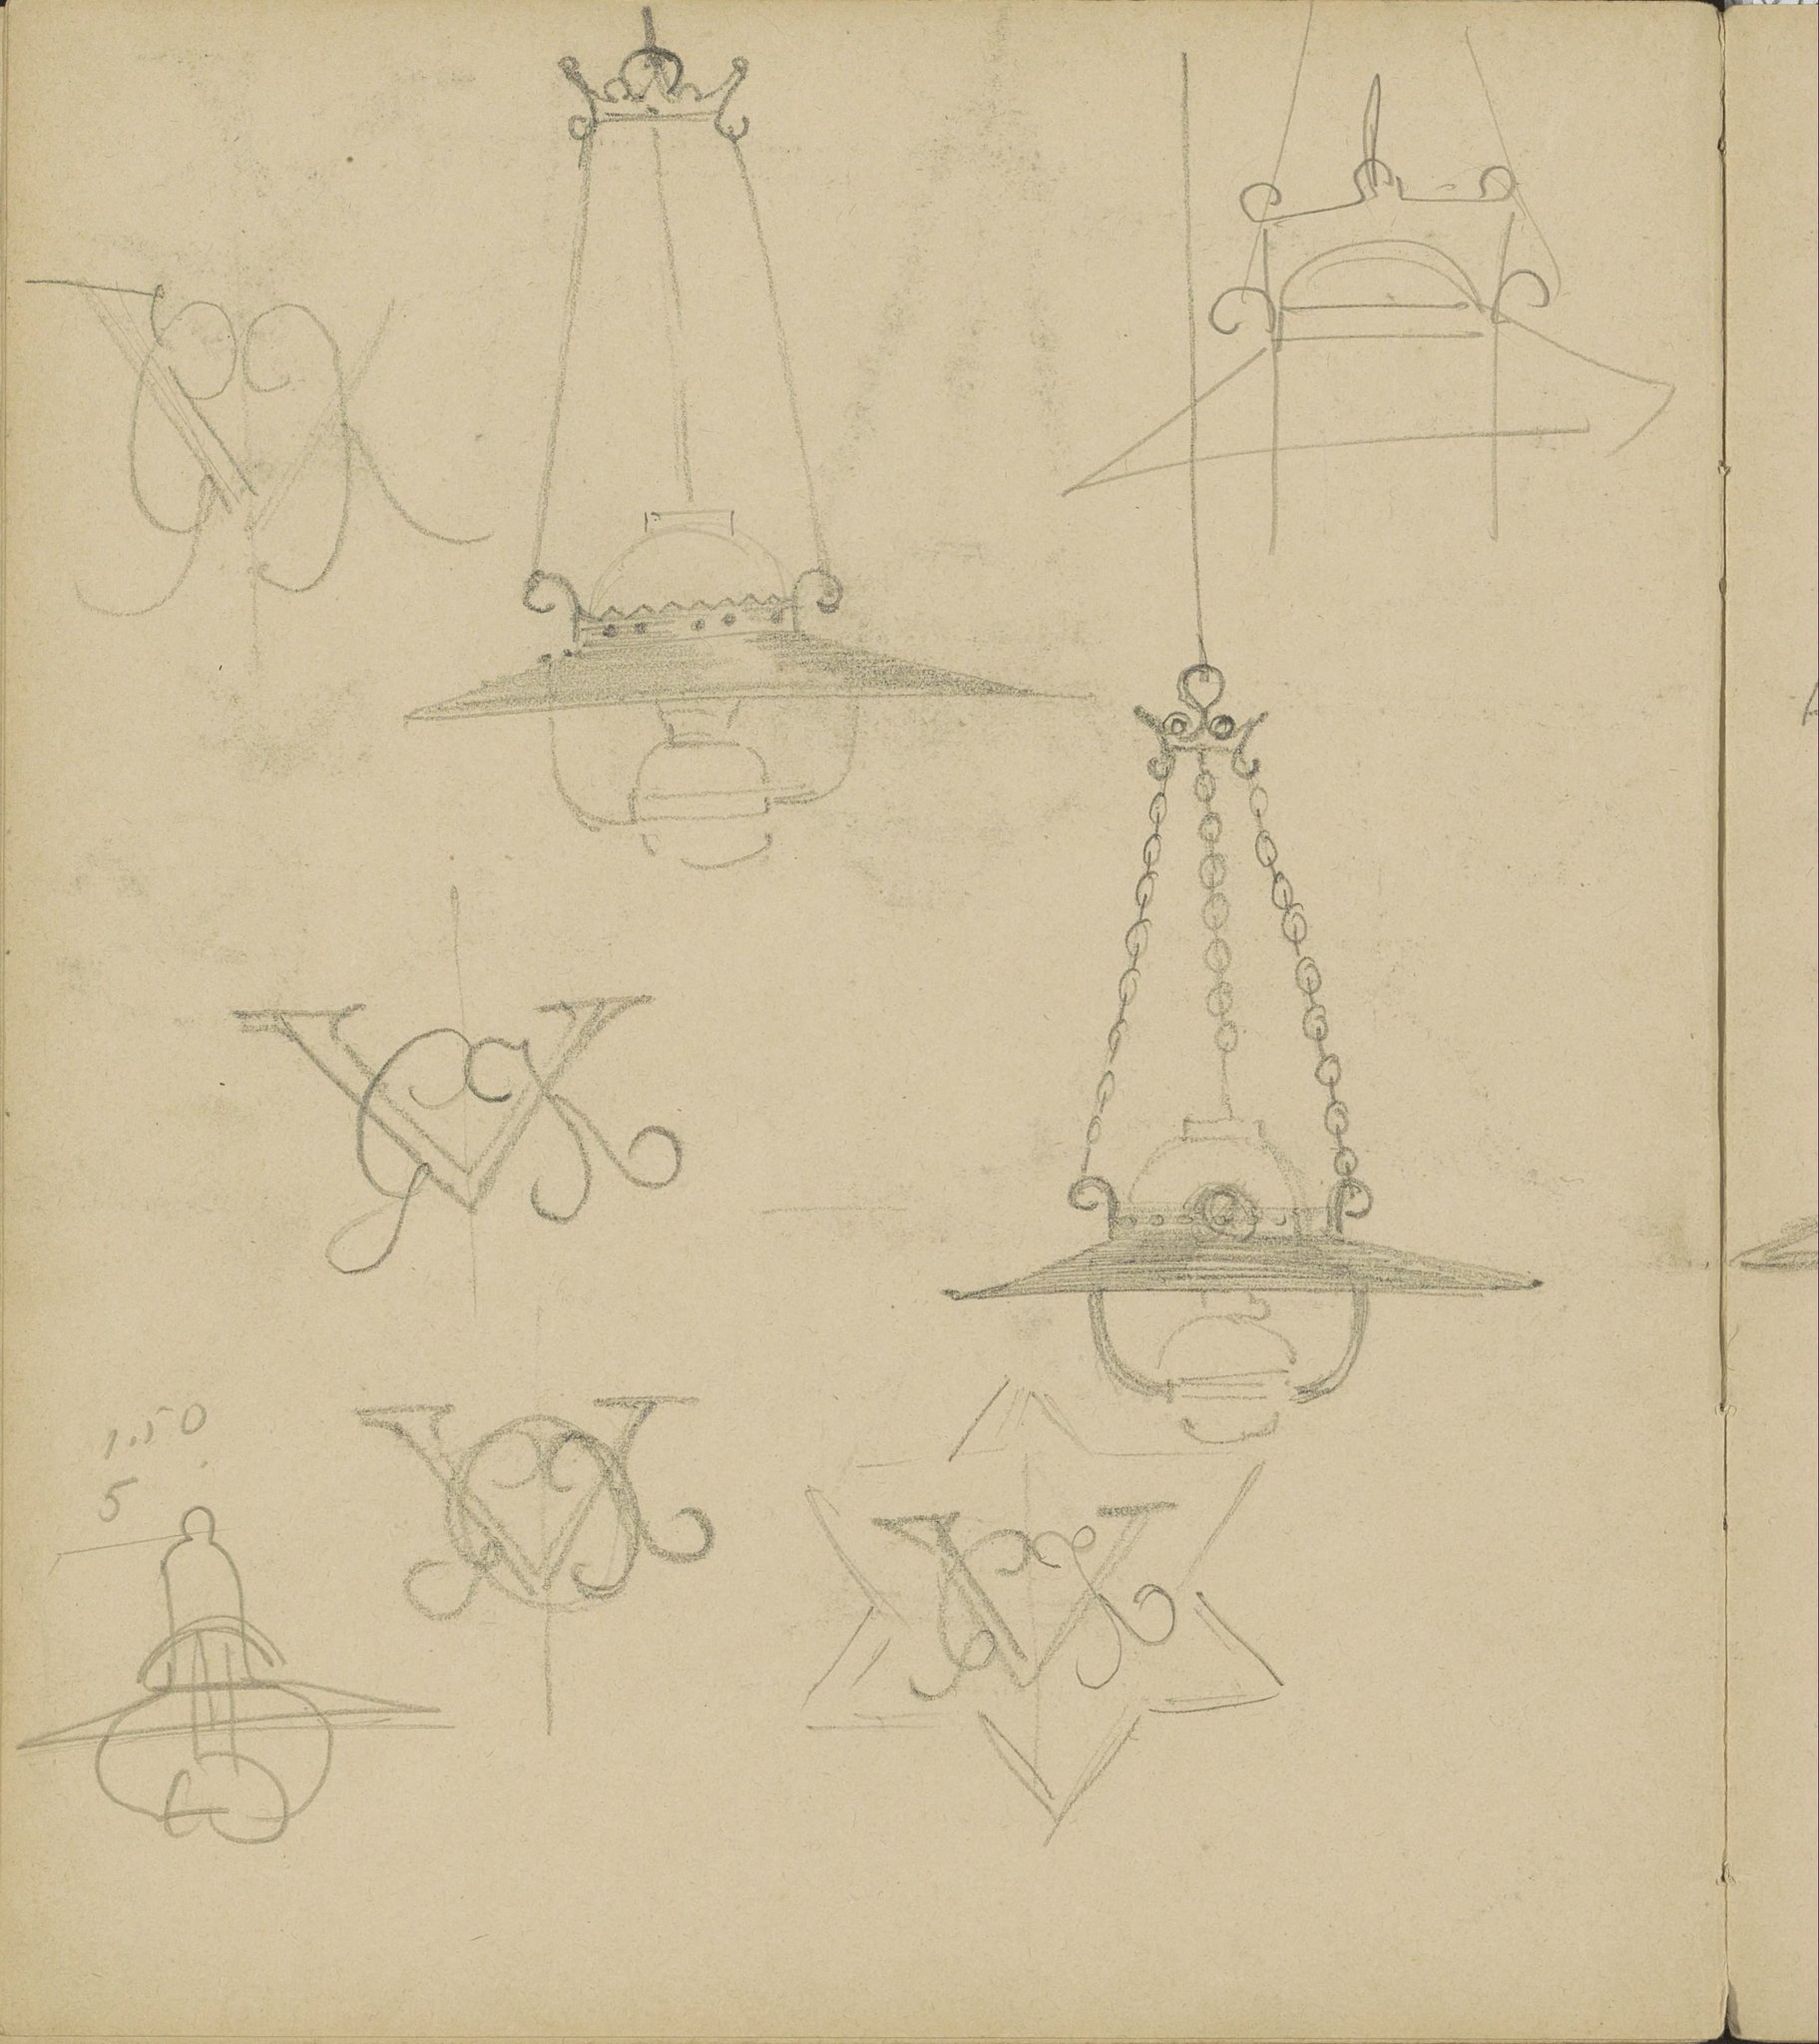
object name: sketchbook leaf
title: Ontwerpen voor hanglampen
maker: carel adolph lion cachet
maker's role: draughtsman, print maker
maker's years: 1864-1945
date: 1905-1906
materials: paper, pencil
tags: lighting; lamps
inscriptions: annotation: ‘[...]’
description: Blad 18 verso uit een schetsboek met 30 bladen.